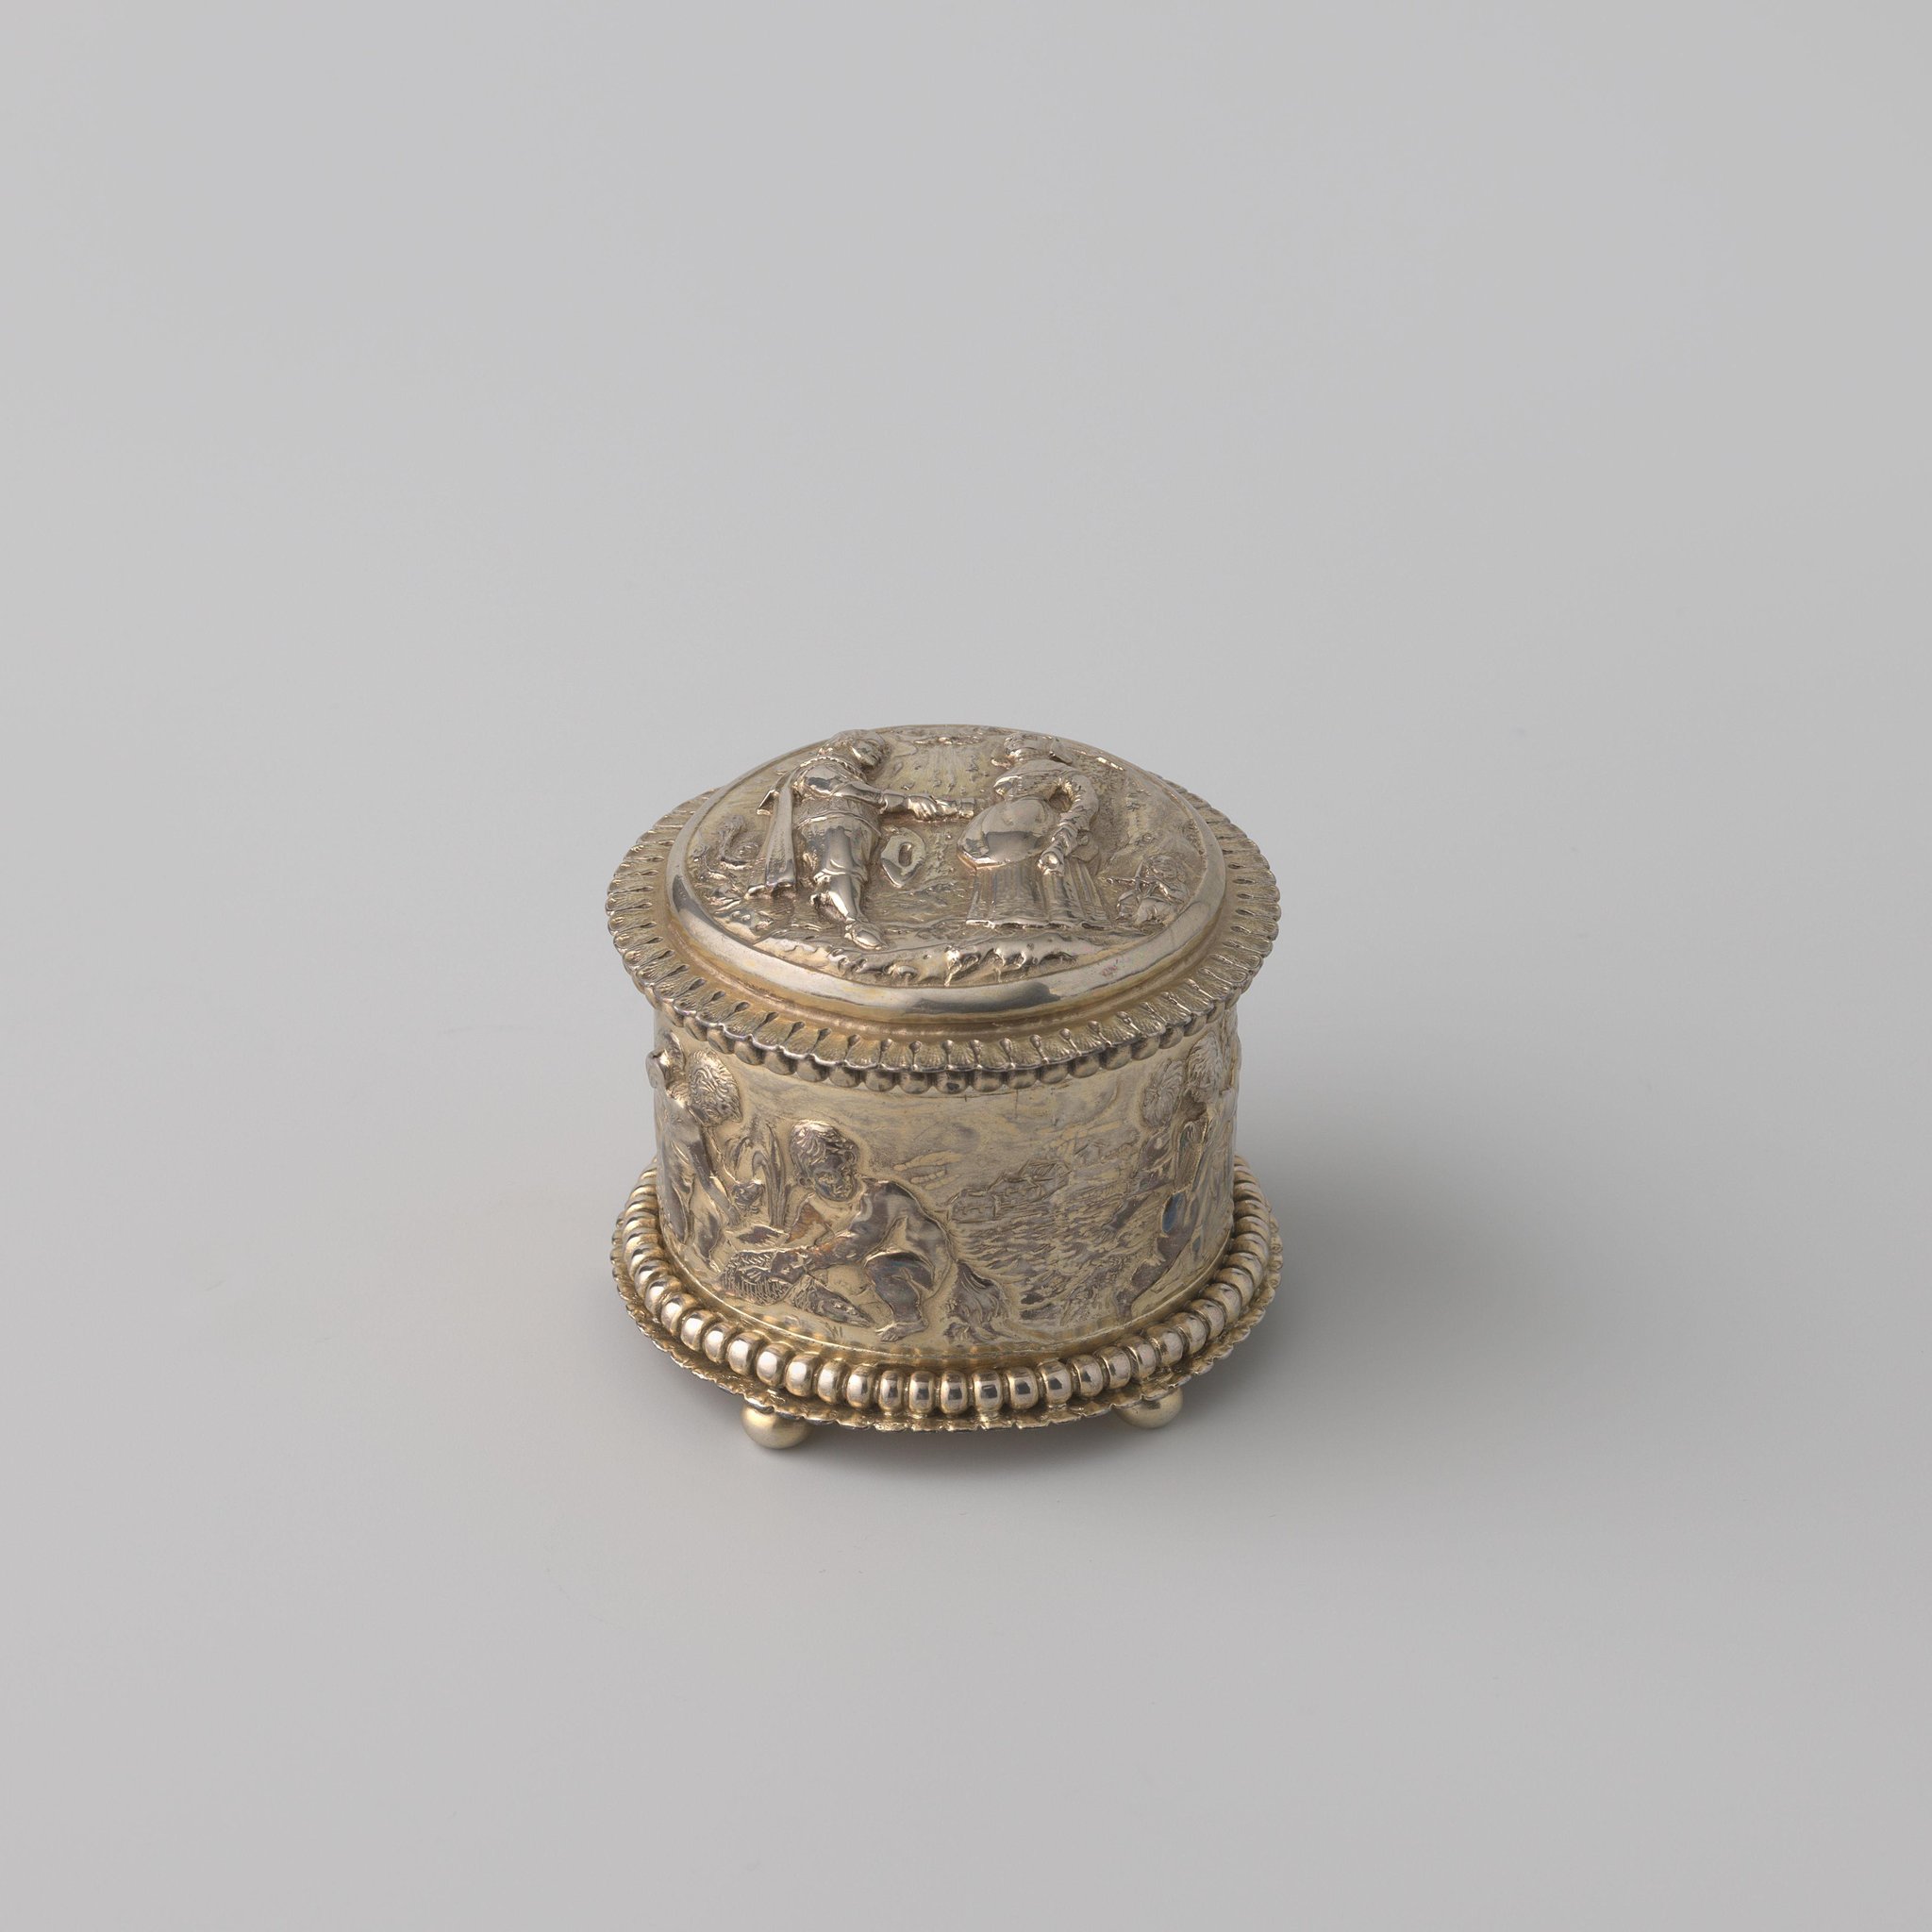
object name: box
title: Knottedoos op vijf bolpoten, versierd met gedreven voorstellingen: op deksel man en vrouw; wand met spelende, vissende en dansende putti.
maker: johannes harmens brunsvelt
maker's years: 1611-1637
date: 1625-1674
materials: silver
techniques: gilding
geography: leeuwarden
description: Wedding box. Silver-gilt. Leeuwarden, c. 1635, by Johannes Harmens Brunsvelt.